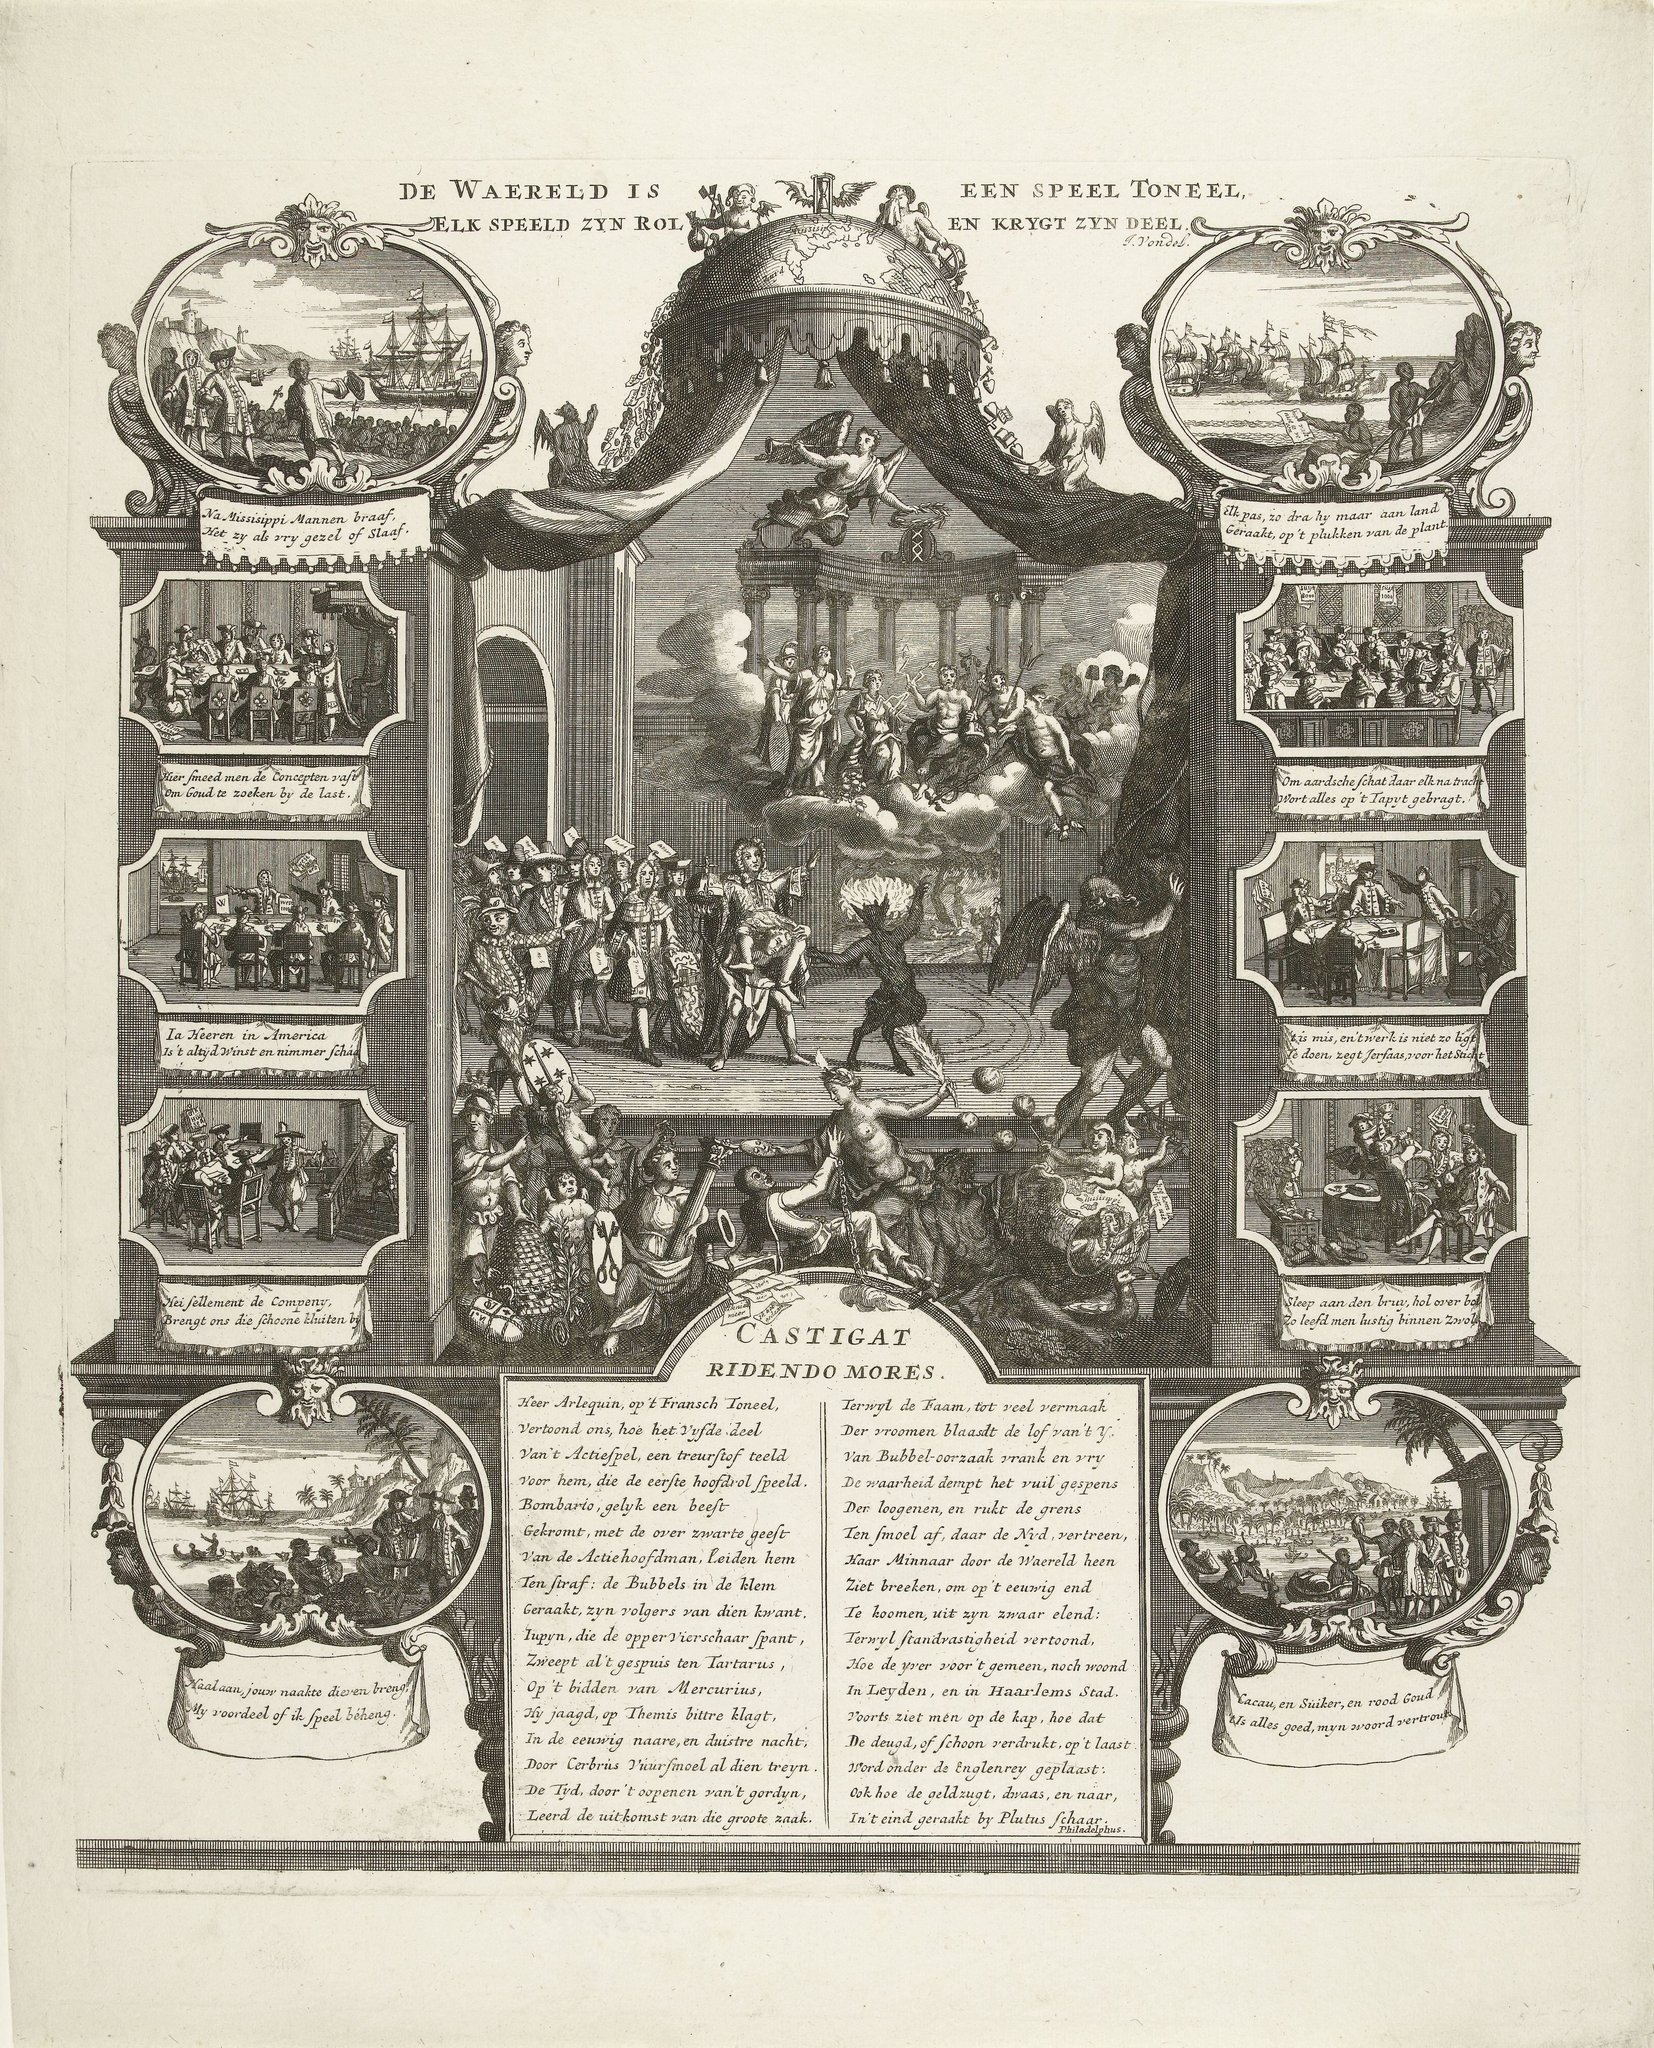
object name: print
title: De Waereld is een Speel Toneel, elk speeld zyn rol en krygt zyn deel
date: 1720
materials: paper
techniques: etching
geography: northern netherlands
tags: master ~ enslaved person, slave-trade, financial panic, theatre, theatrical performance, slavery; serfs and enslaved persons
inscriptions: collector's mark: Lugt 2228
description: De wereld is een speeltoneel. Op een toneel onder een troonhemel worden windhandelaren ontvangen door de duivel, in de wolken de goden bij een zuilengalerij met het wapen van Amsterdam, op de voorgrond allerlei personificaties. Links en rechts kleinere scènes van de windhandel in verschillende streken en steden. Linksboven tot slaaf gemaakte Afrikanen bij de Mississippi-Compagnie. Ook rechtsboven, links- en rechtsonder voorstellingen met betrekking tot de slavernij. Onderaan een vers van Philadelphus. Prent 19 in de serie Het Groote Tafereel der Dwaasheid met spotprenten op de Windhandel of Actiehandel van 1720.